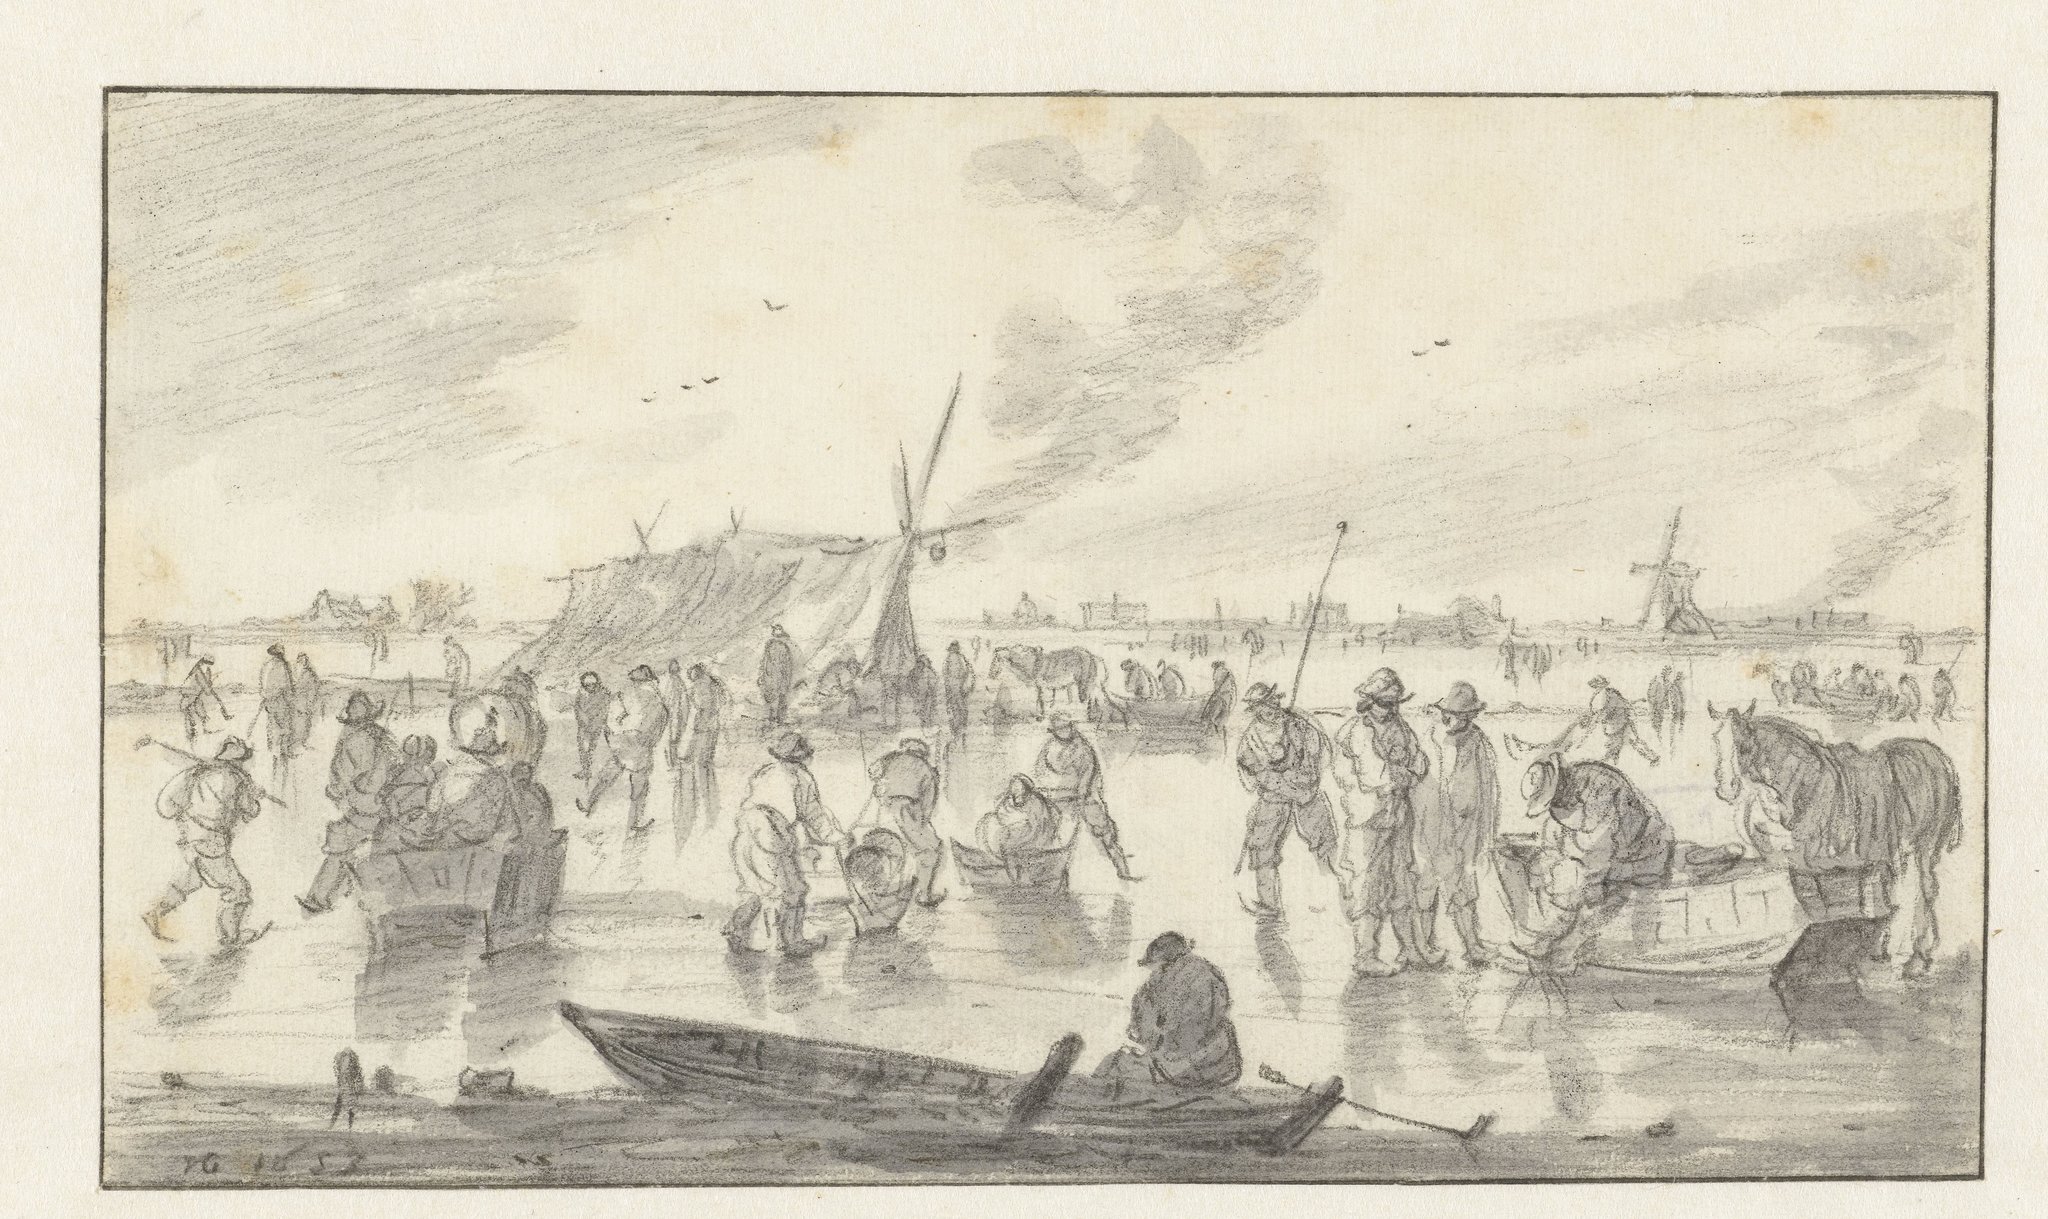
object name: drawing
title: IJsvermaak op een brede rivier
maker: jan van goyen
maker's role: draughtsman, painter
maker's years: 1596-1656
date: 1653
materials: chalk, paper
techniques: brush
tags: winter sports, ice ~ freezing weather